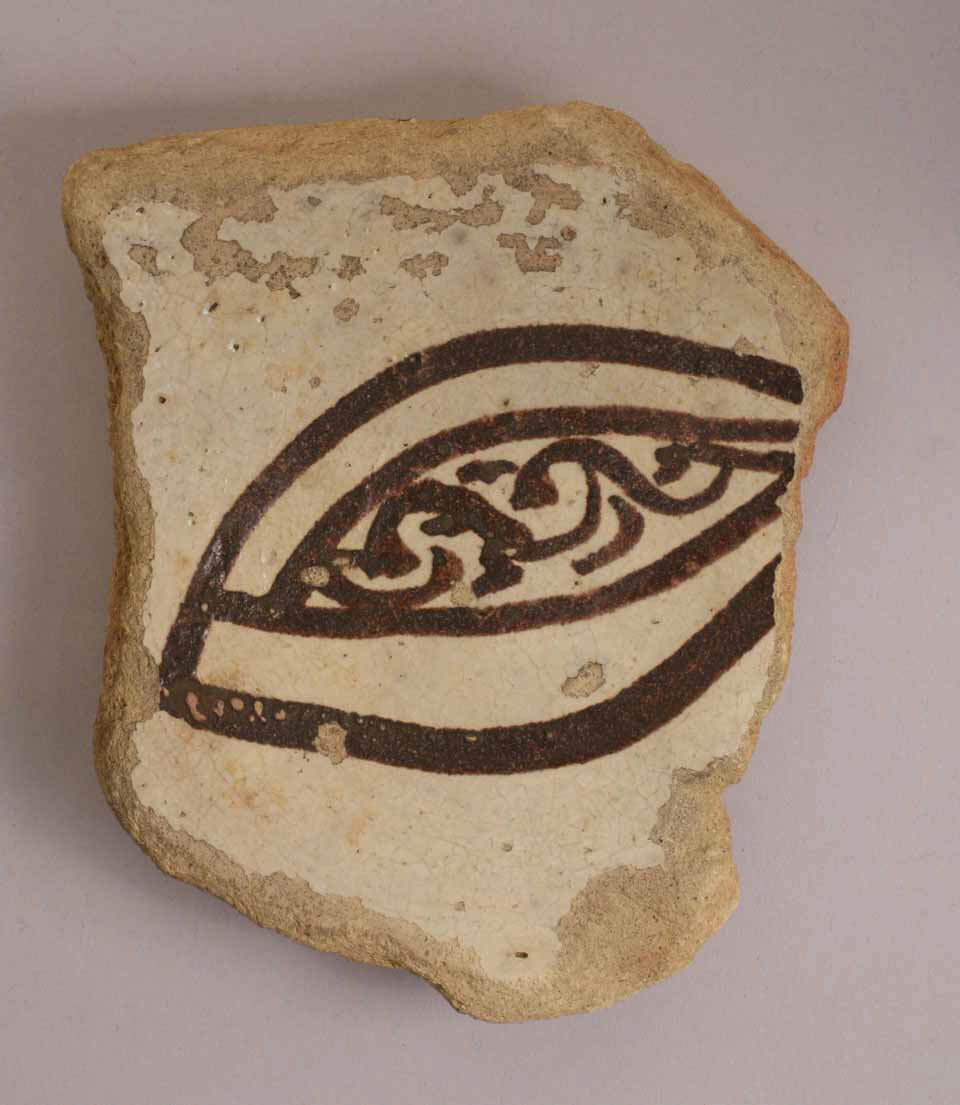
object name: ceramic fragment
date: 1101-1300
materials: earthenware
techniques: glazing, painting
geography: egypt or syria